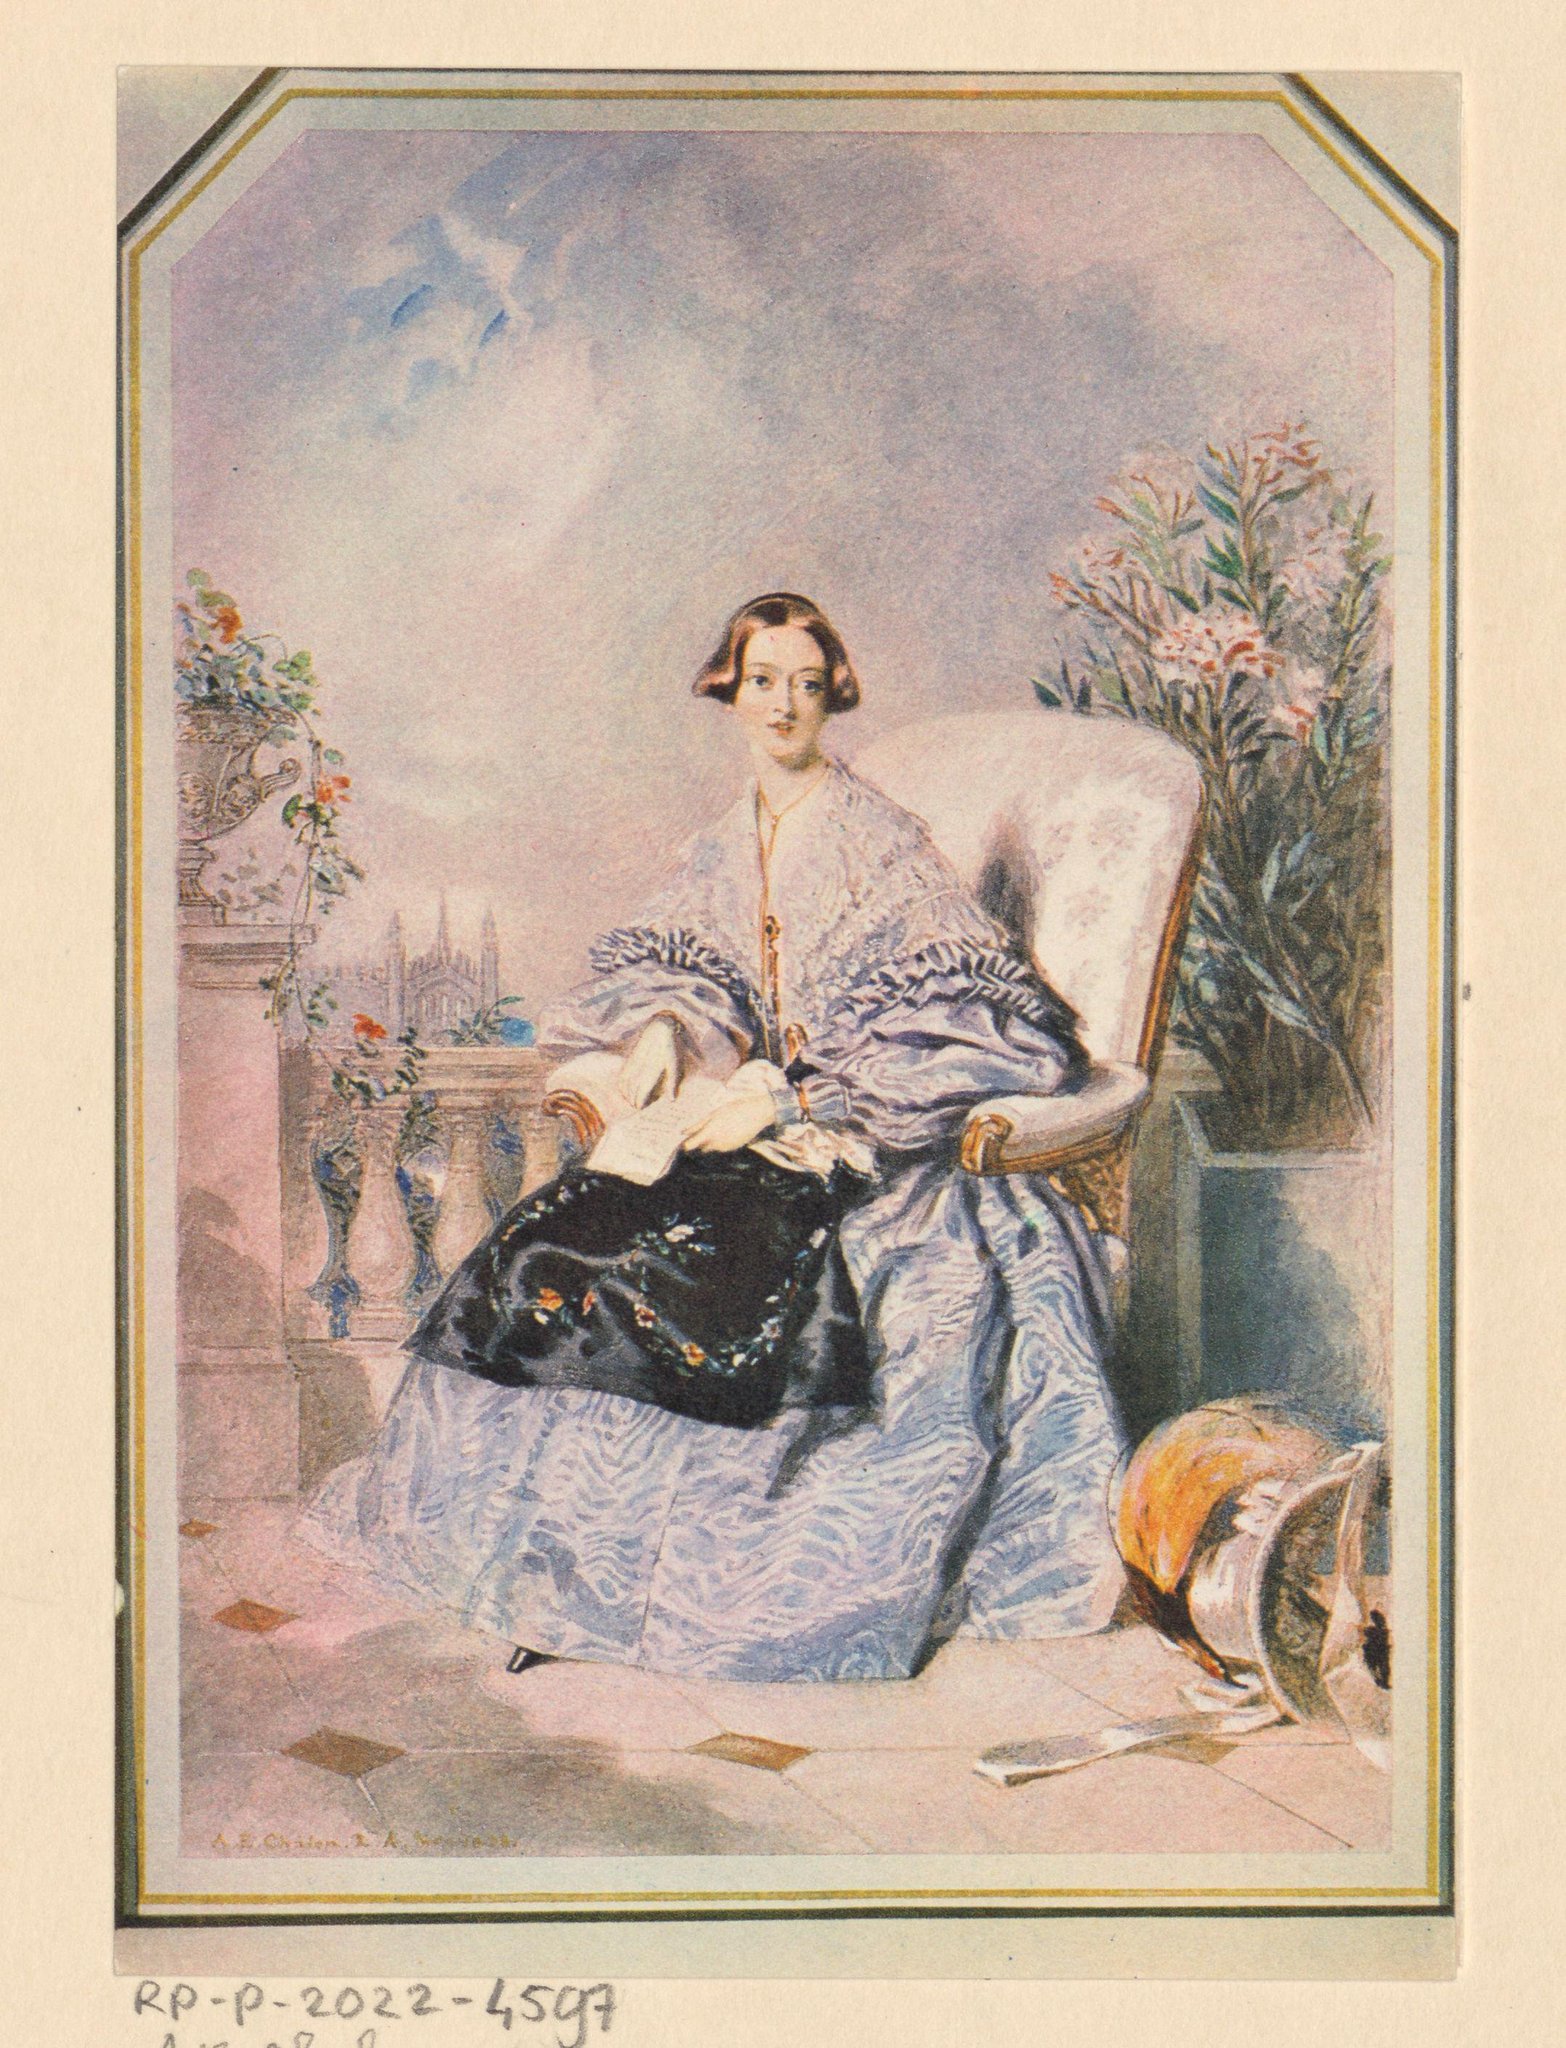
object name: photomechanical print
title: Portret van koningin Victoria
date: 1937-1958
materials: paper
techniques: collotype process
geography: inverness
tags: victoria (koningin van het verenigd koninkrijk en keizerin van india), historical persons - bb - woman, queen